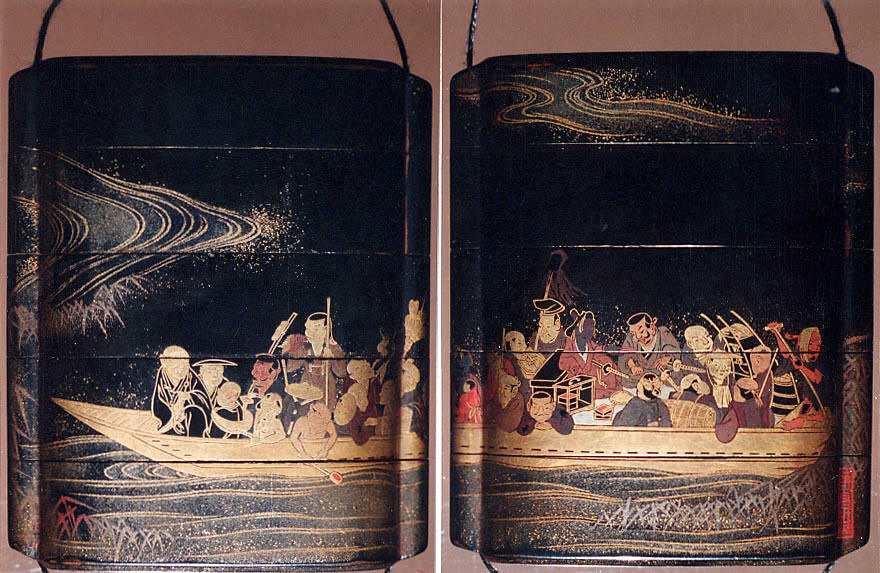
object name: inrō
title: Case (Inrō) with Design of Crowded Ferry Boat on Waves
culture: japanese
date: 1701-1733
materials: gold, lacquer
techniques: fundame, roiro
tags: waves,crowd,boats